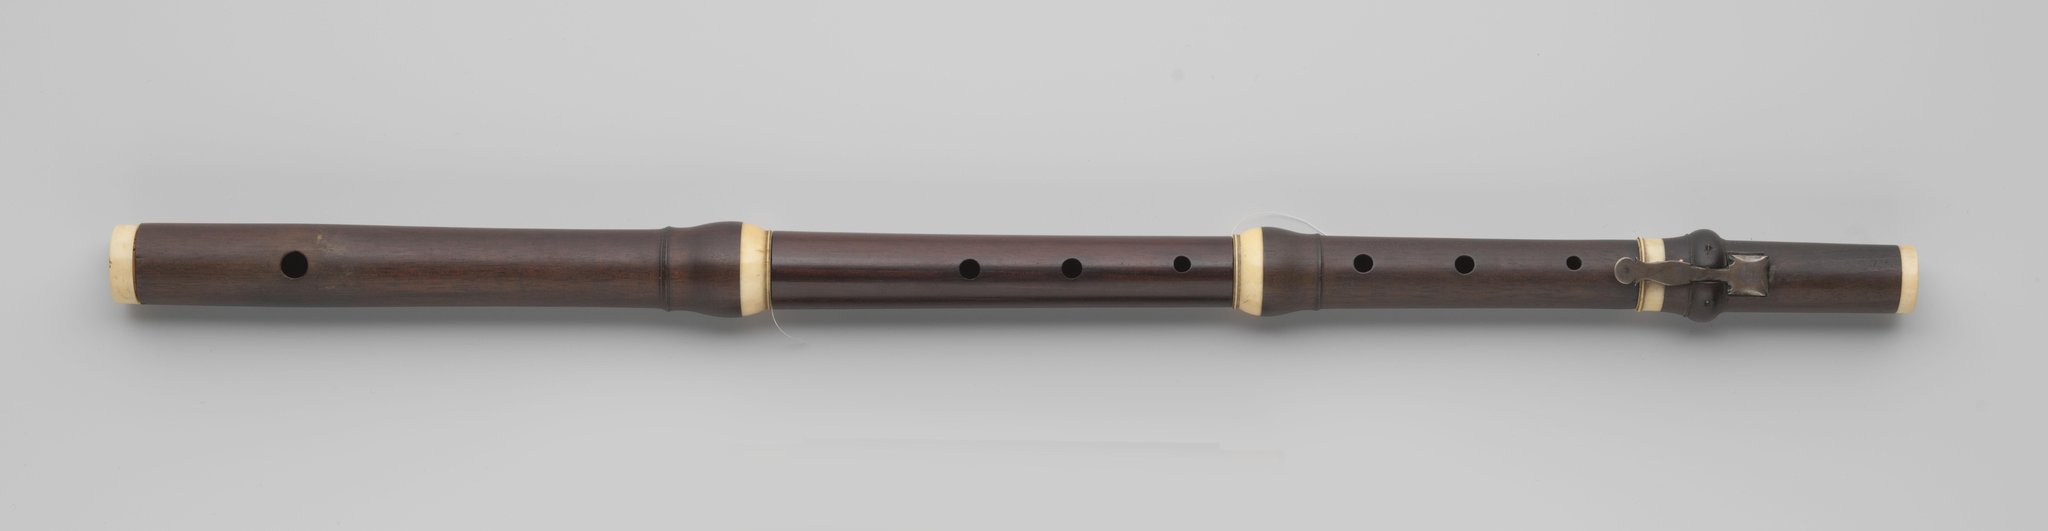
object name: transverse flute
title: Dwarsfluit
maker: Anonymous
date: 1750-1800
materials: brass, wood, ivory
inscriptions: stamp: ‘TASSI’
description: Vierdelige dwarsfluit van granadellehout met ivoor ringen en een messing klep. Stemming ca. a=415 Hz.